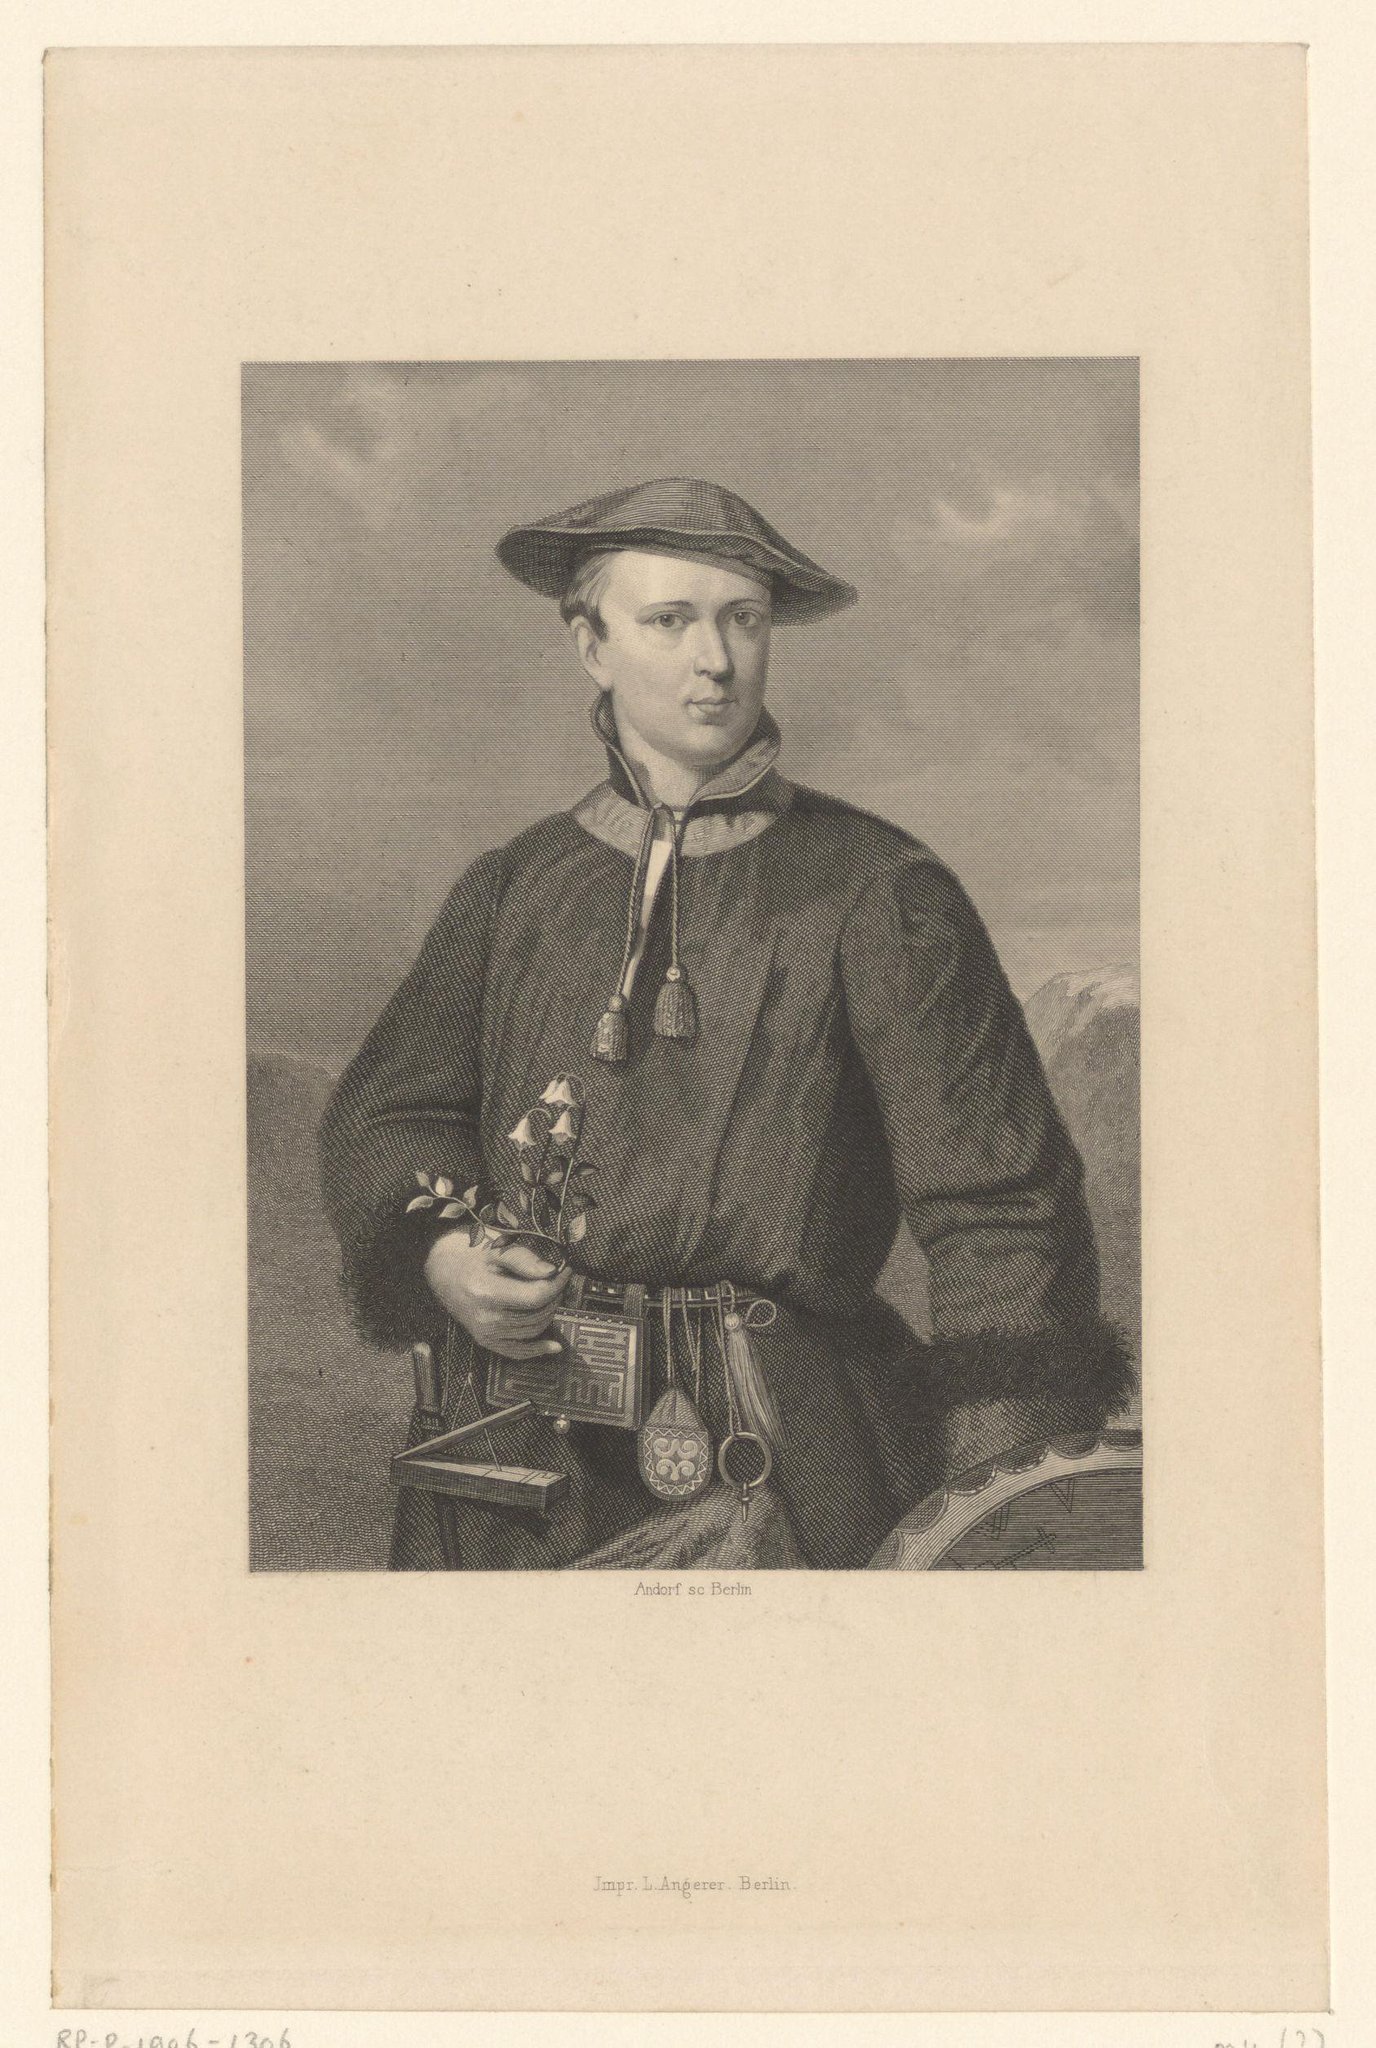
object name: print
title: Portret van Carolus Linnaeus in Laplandse klederdracht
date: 1829-1875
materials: paper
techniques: engraving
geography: berlin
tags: carl linnaeus, europeans: sami, historical persons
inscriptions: collector's mark: Lugt 2228